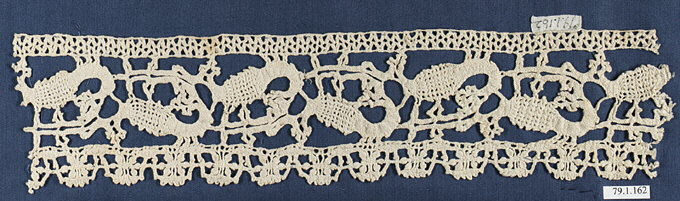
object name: fragment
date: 1600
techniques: lace